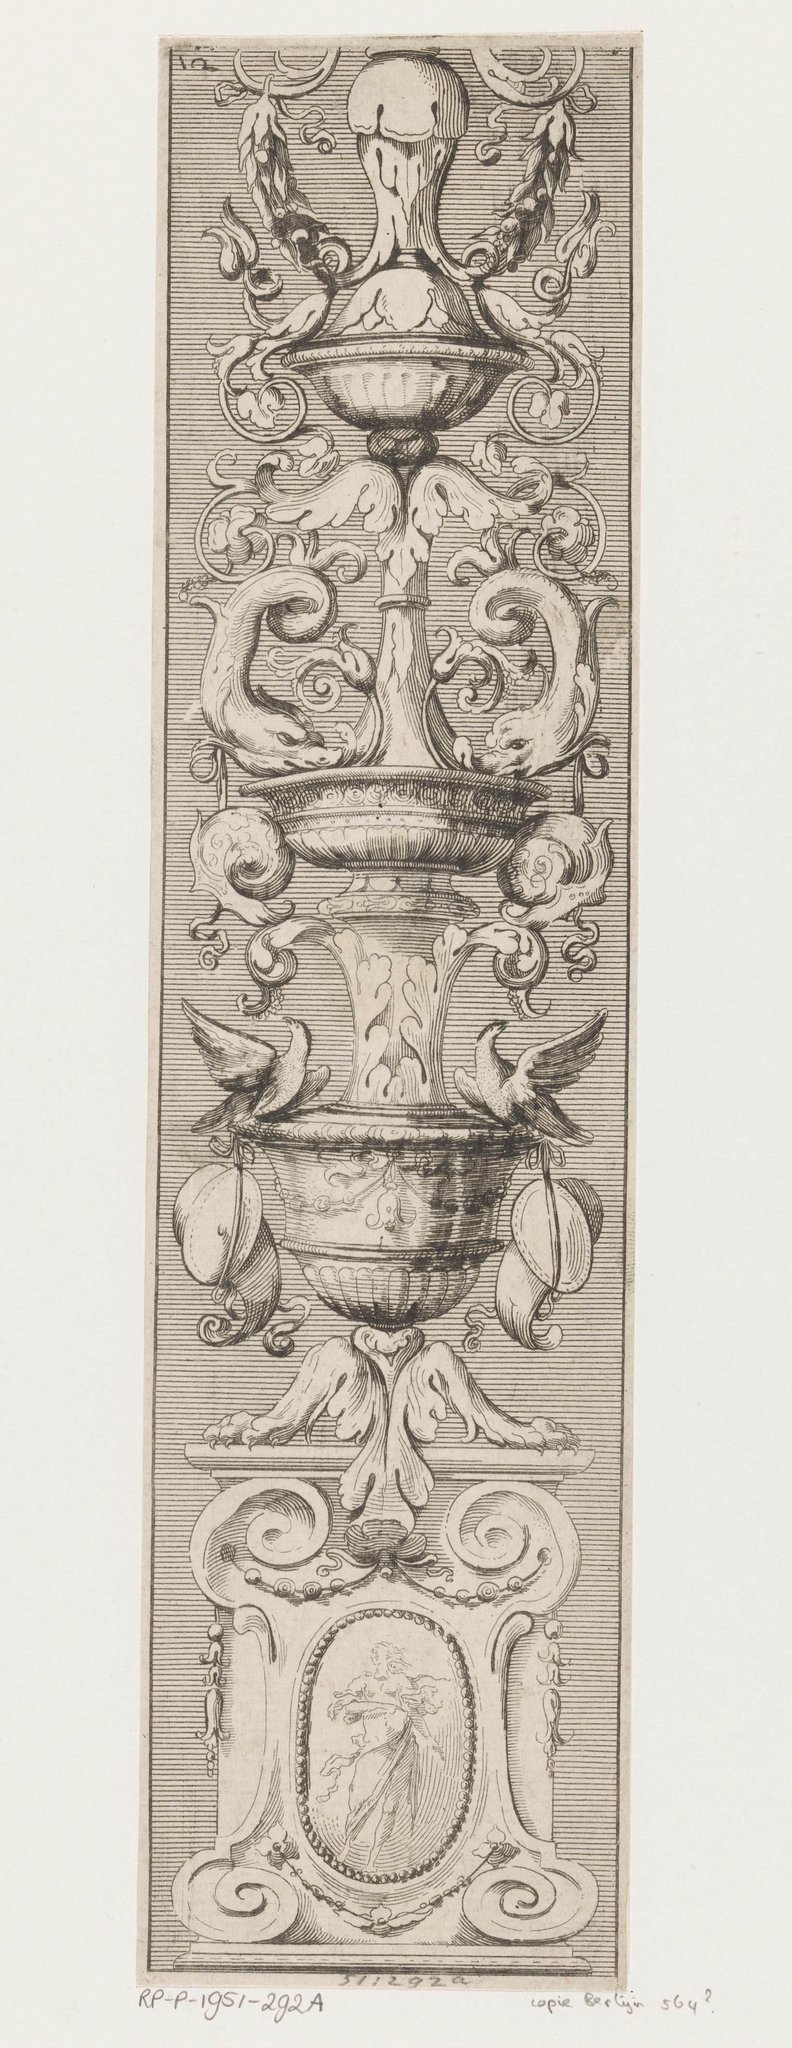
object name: ornament print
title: Kandelaber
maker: Anonymous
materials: paper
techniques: etching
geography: italy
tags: ornament ~ candelabrum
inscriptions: collector's mark: Lugt 2228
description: Deze prent maakt deel uit van een reeks kopieën naar prenten van Agostino Mitelli. Mitelli maakte zijn prenten naar tekeningen van marmeren pilasterdecoraties van de poort van de S. Bartolomeo di Porta Ravegnana in Bologna.